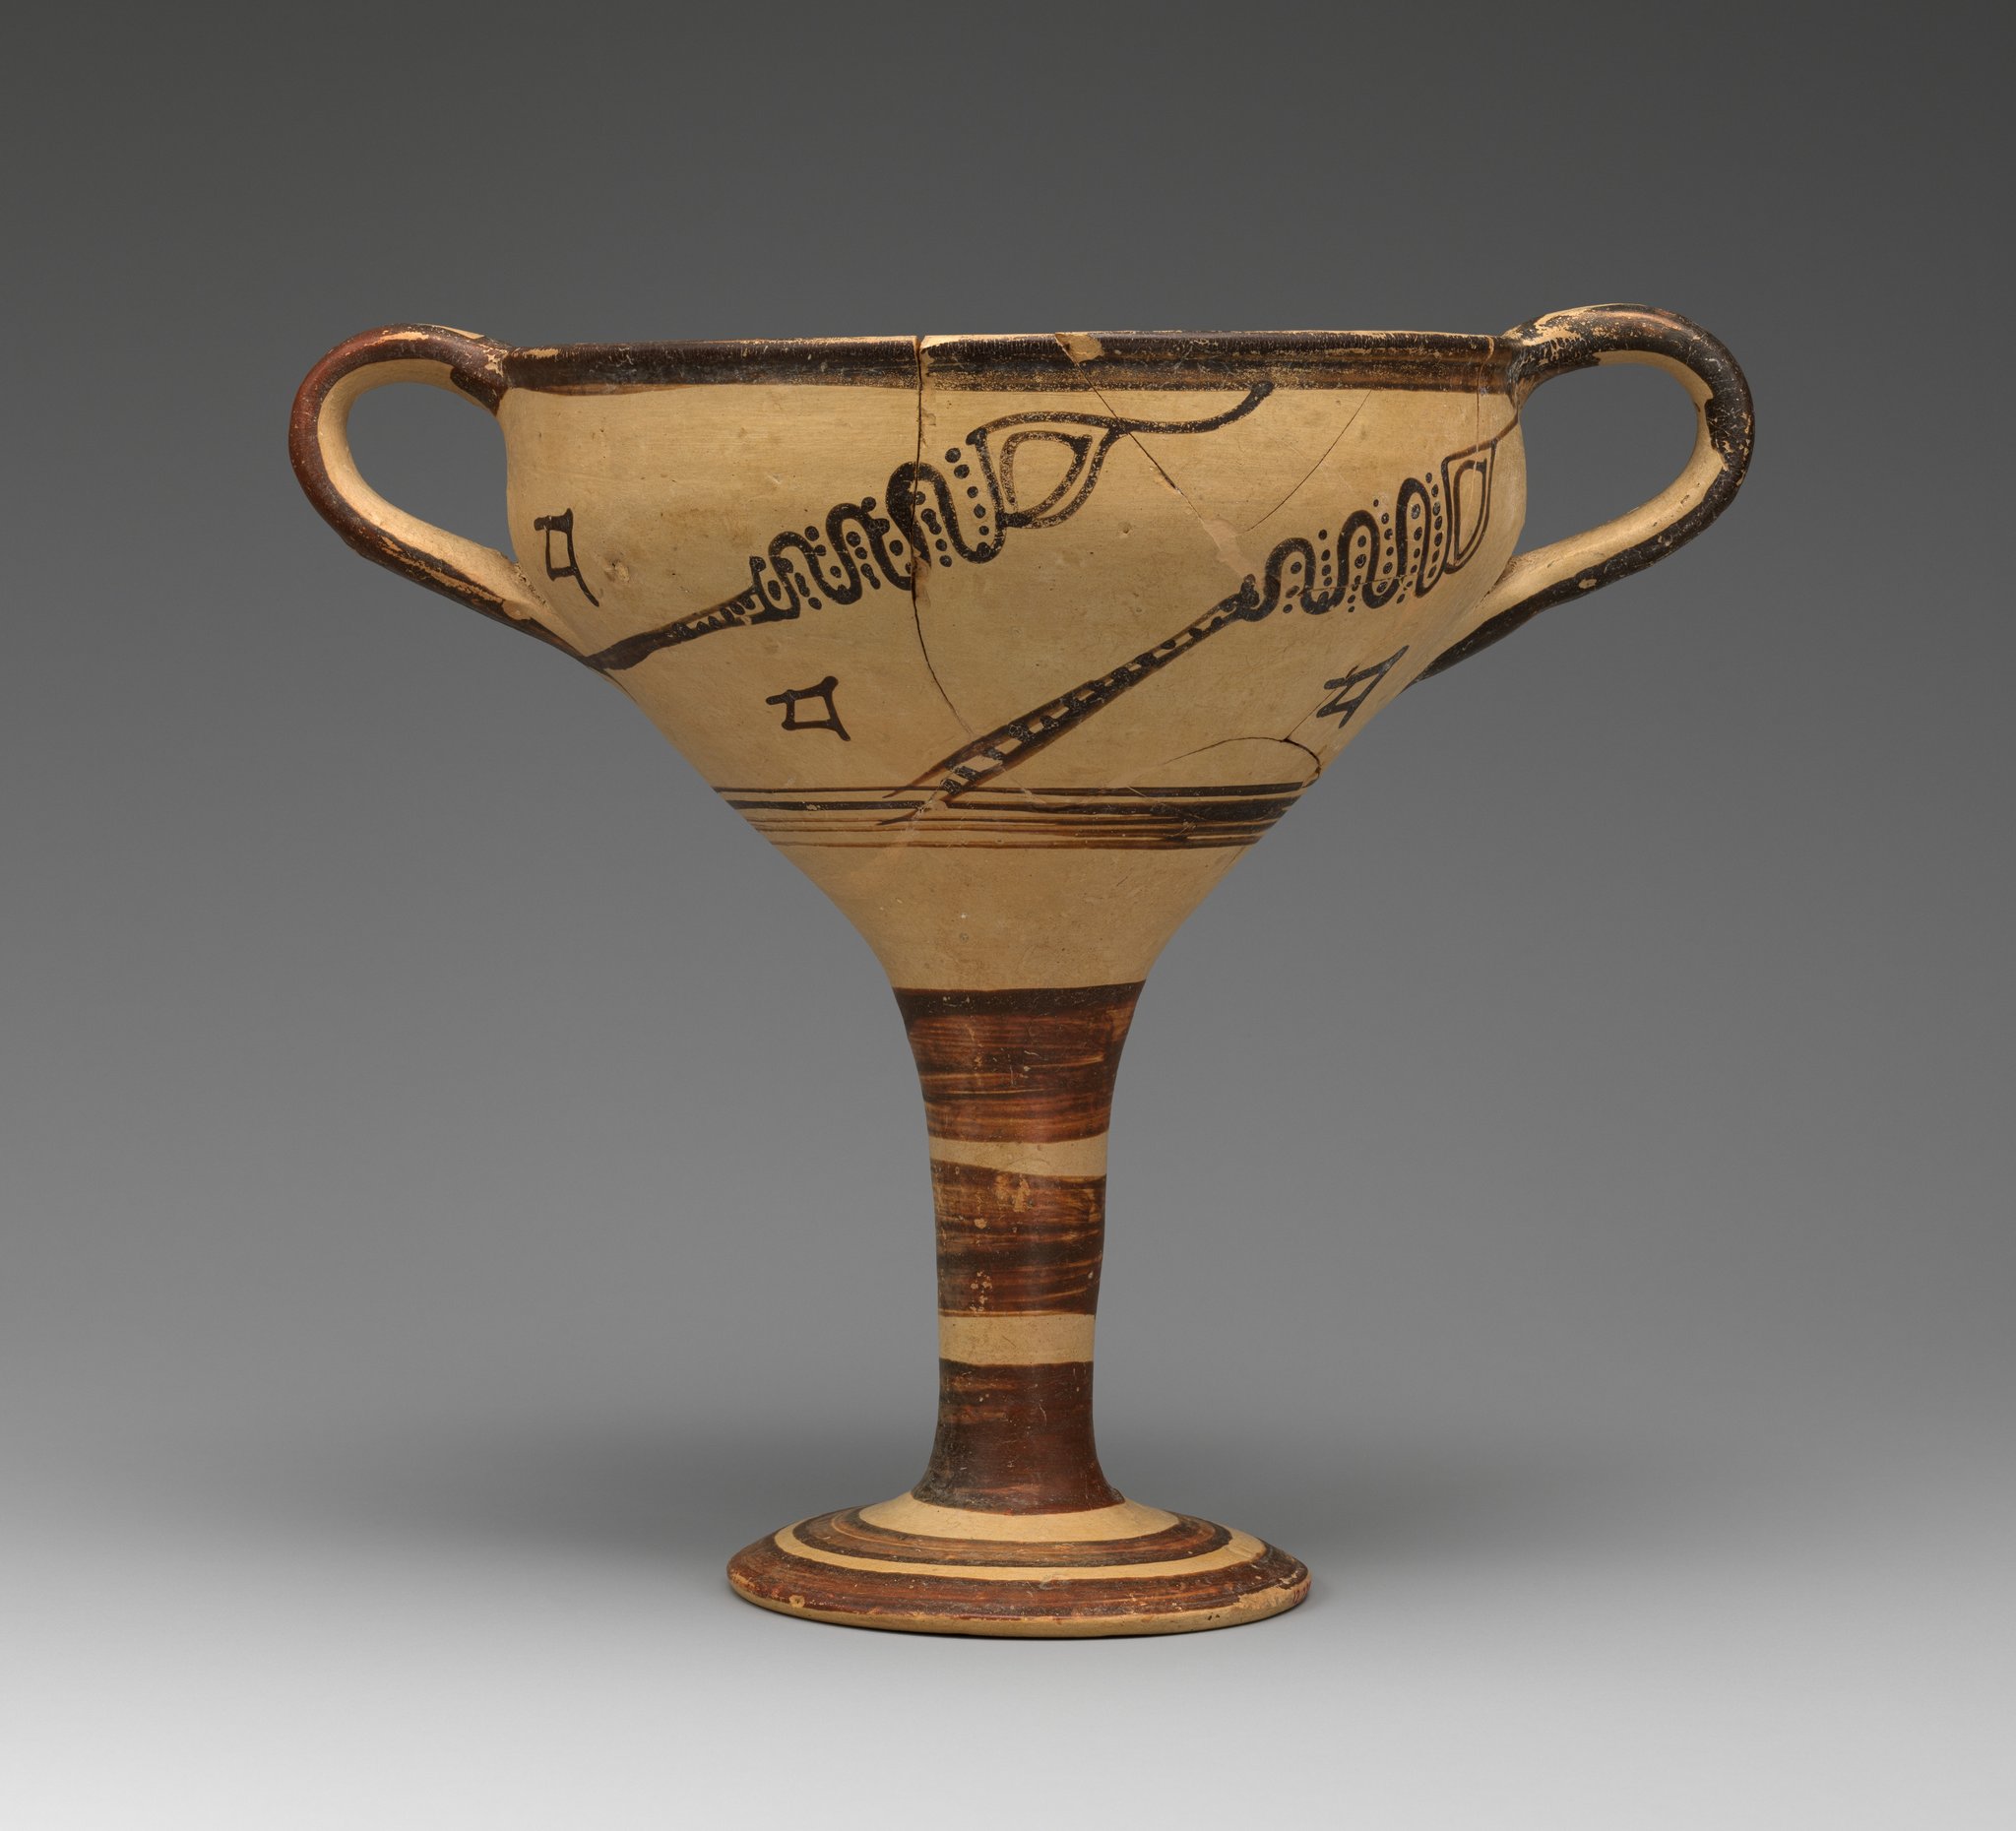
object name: cup, stemmed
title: Terracotta stemmed cup with murex decoration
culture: aegean, helladic or mycenaean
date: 1400-1300 BCE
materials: terracotta